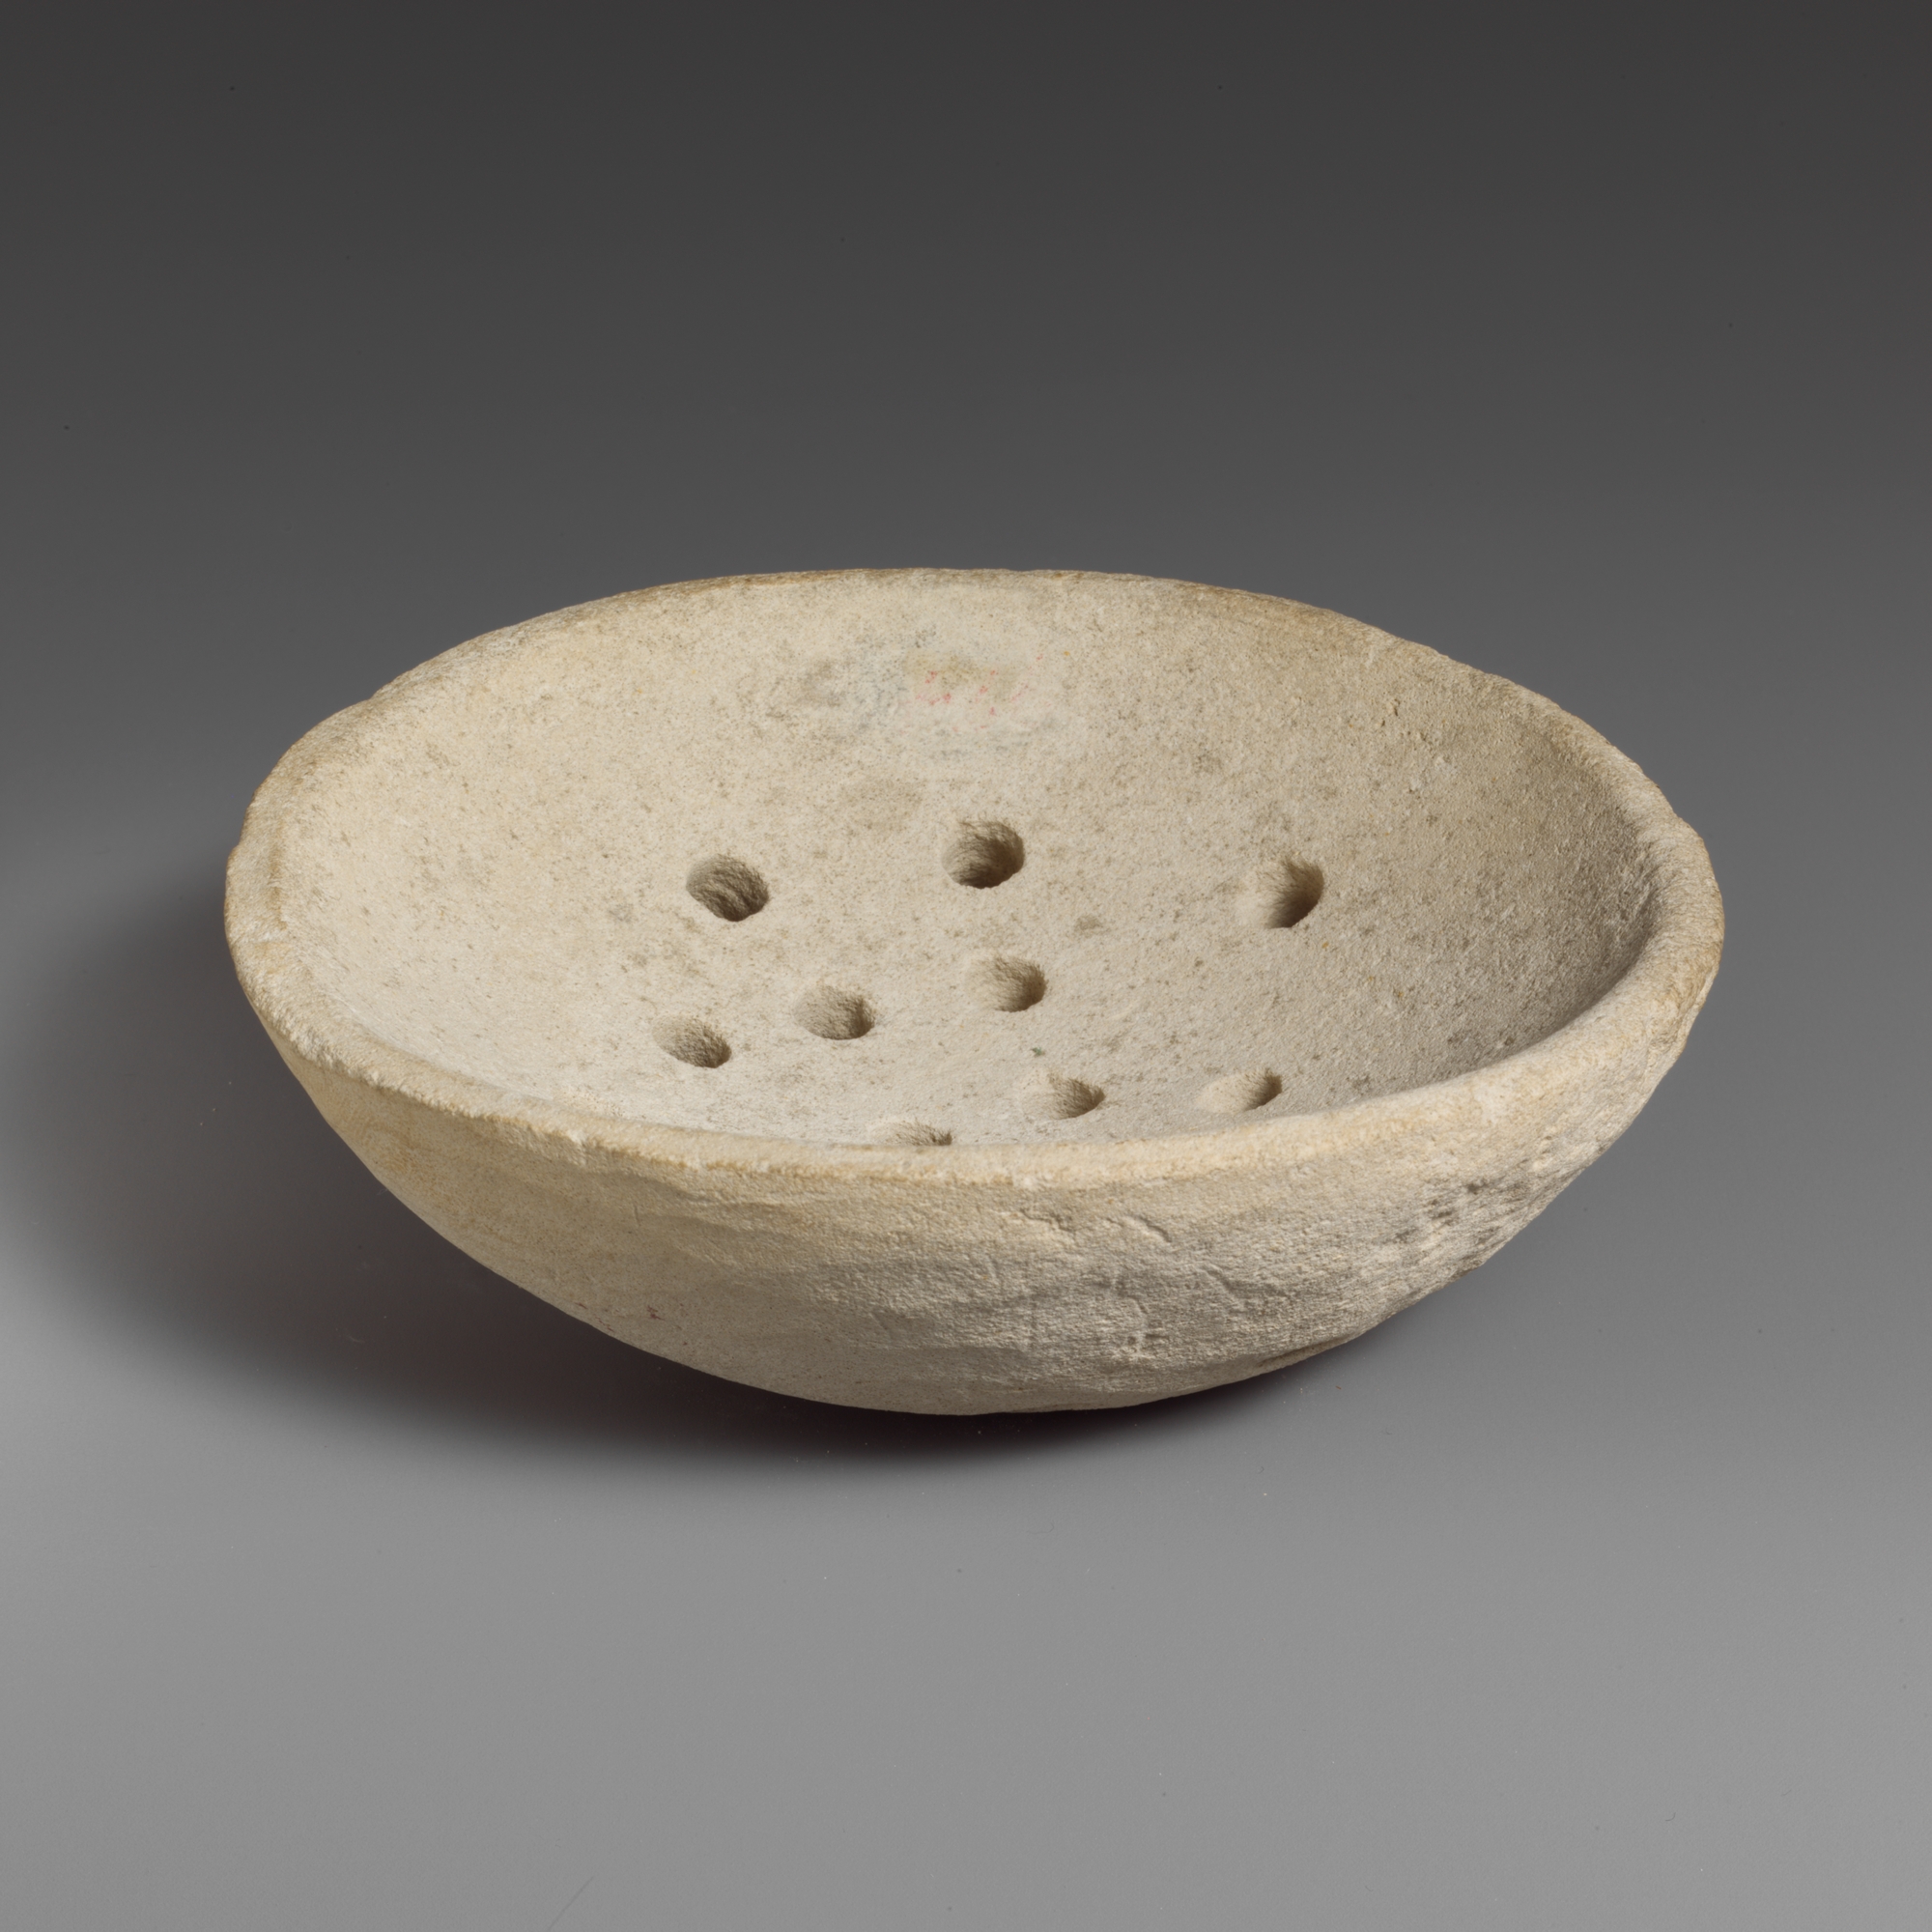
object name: strainer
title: Limestone strainer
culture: cypriot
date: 3900 BCE-100 CE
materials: limestone